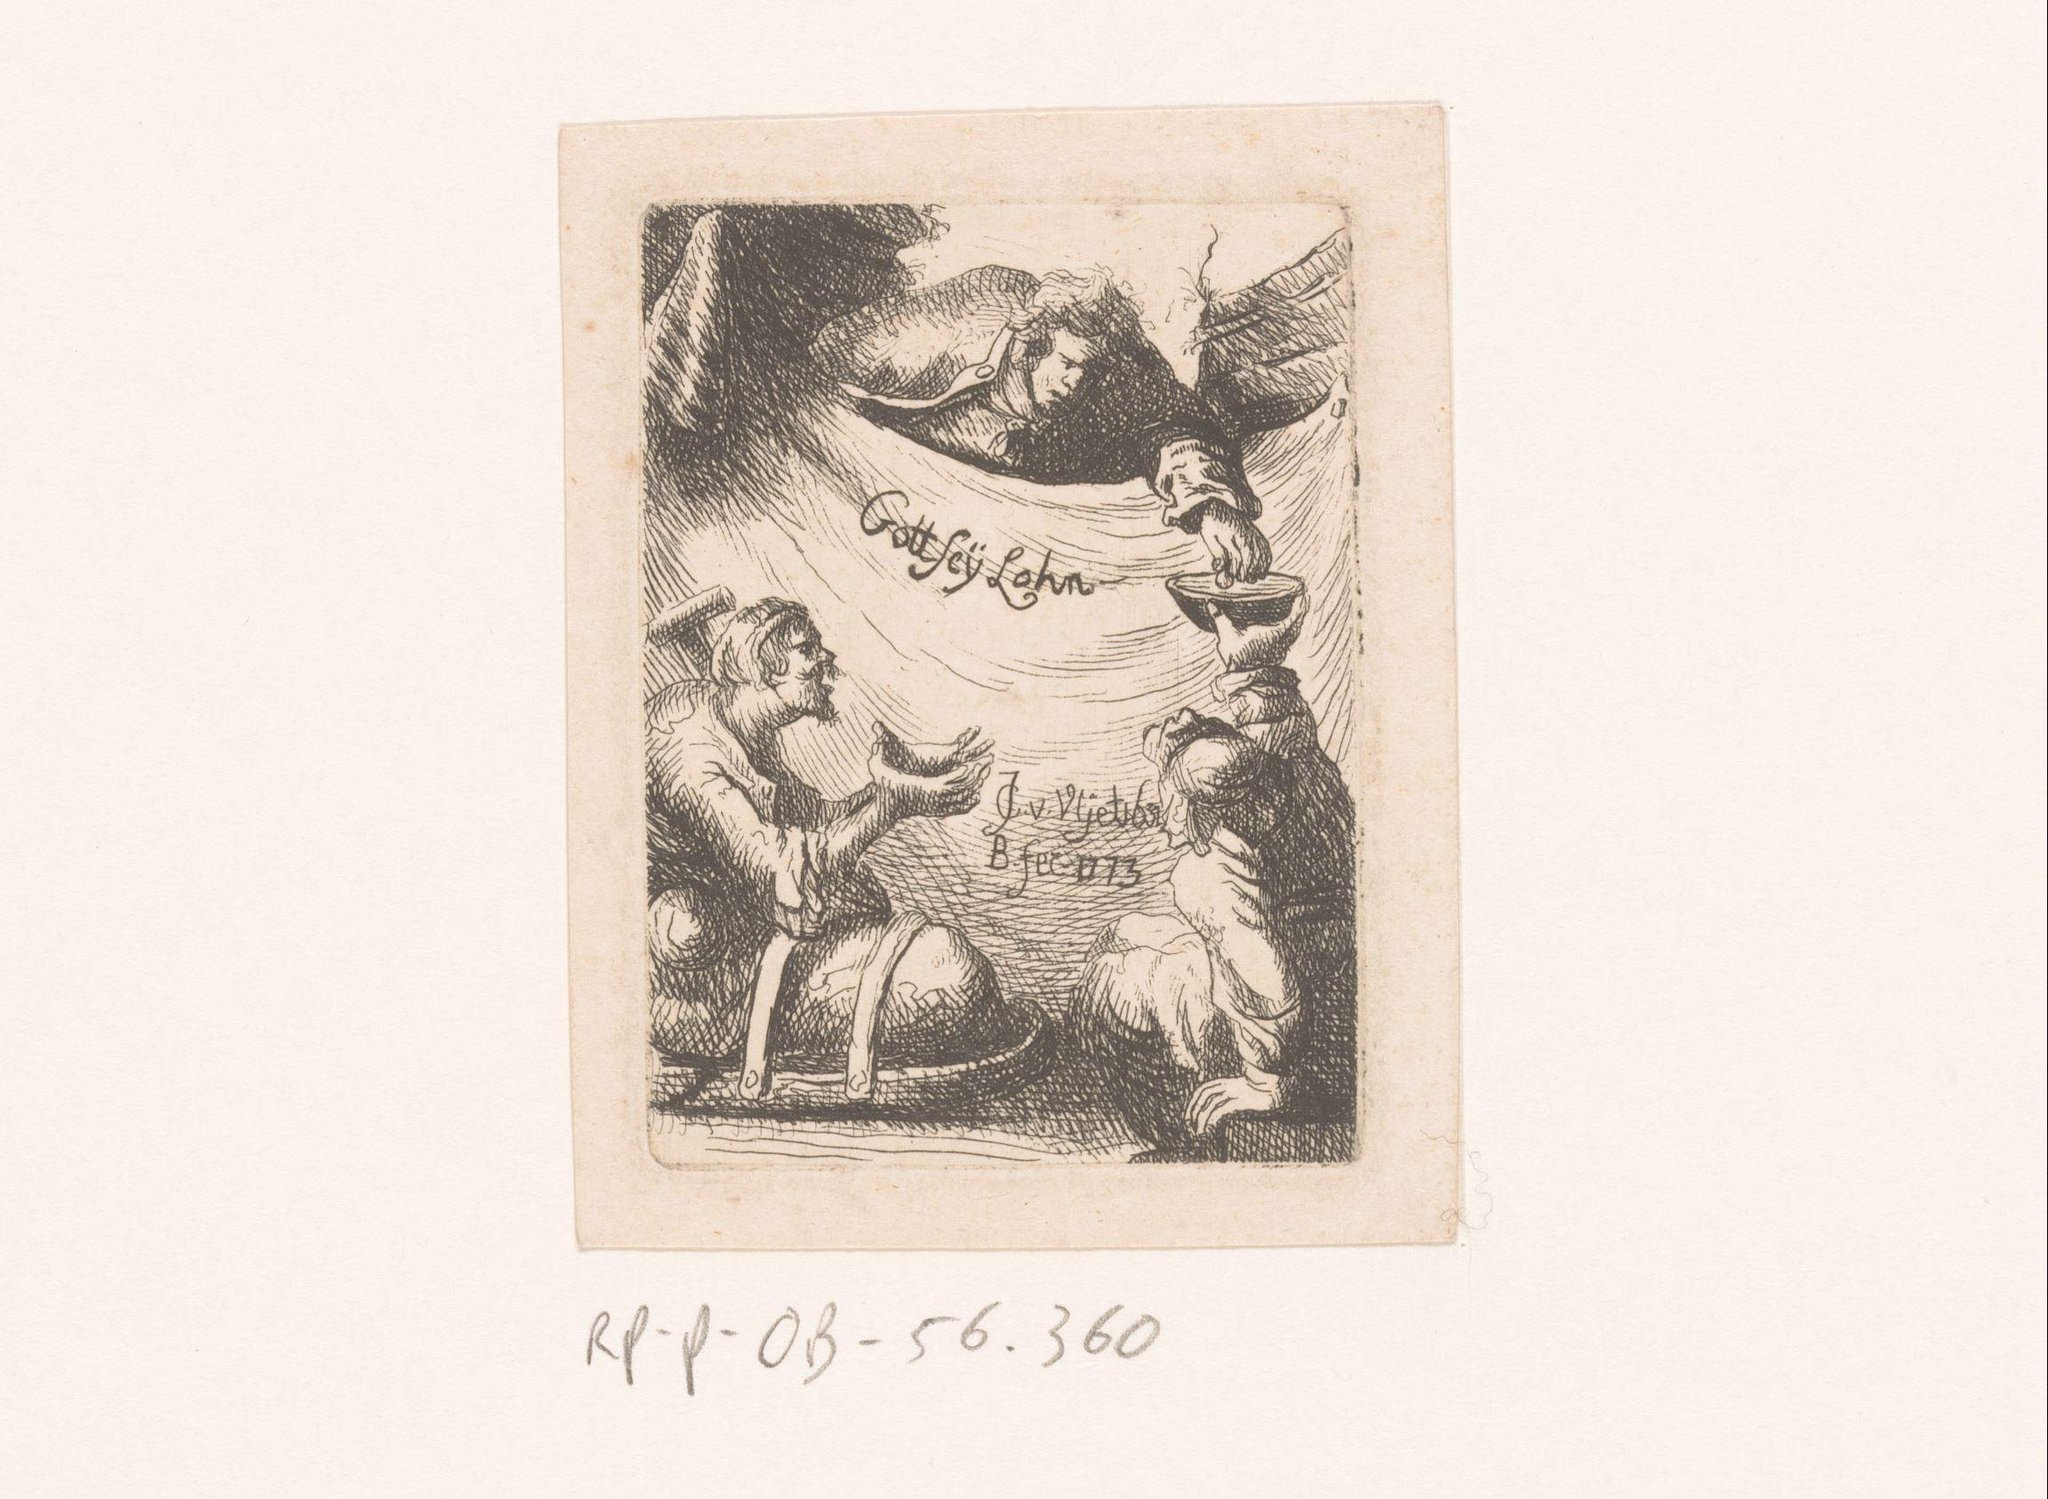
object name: print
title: Man geeft geld aan twee bedelaars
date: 1773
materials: paper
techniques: etching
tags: giving alms or other charity, e.g.: handing out food, beggar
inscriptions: collector's mark: Lugt 2228